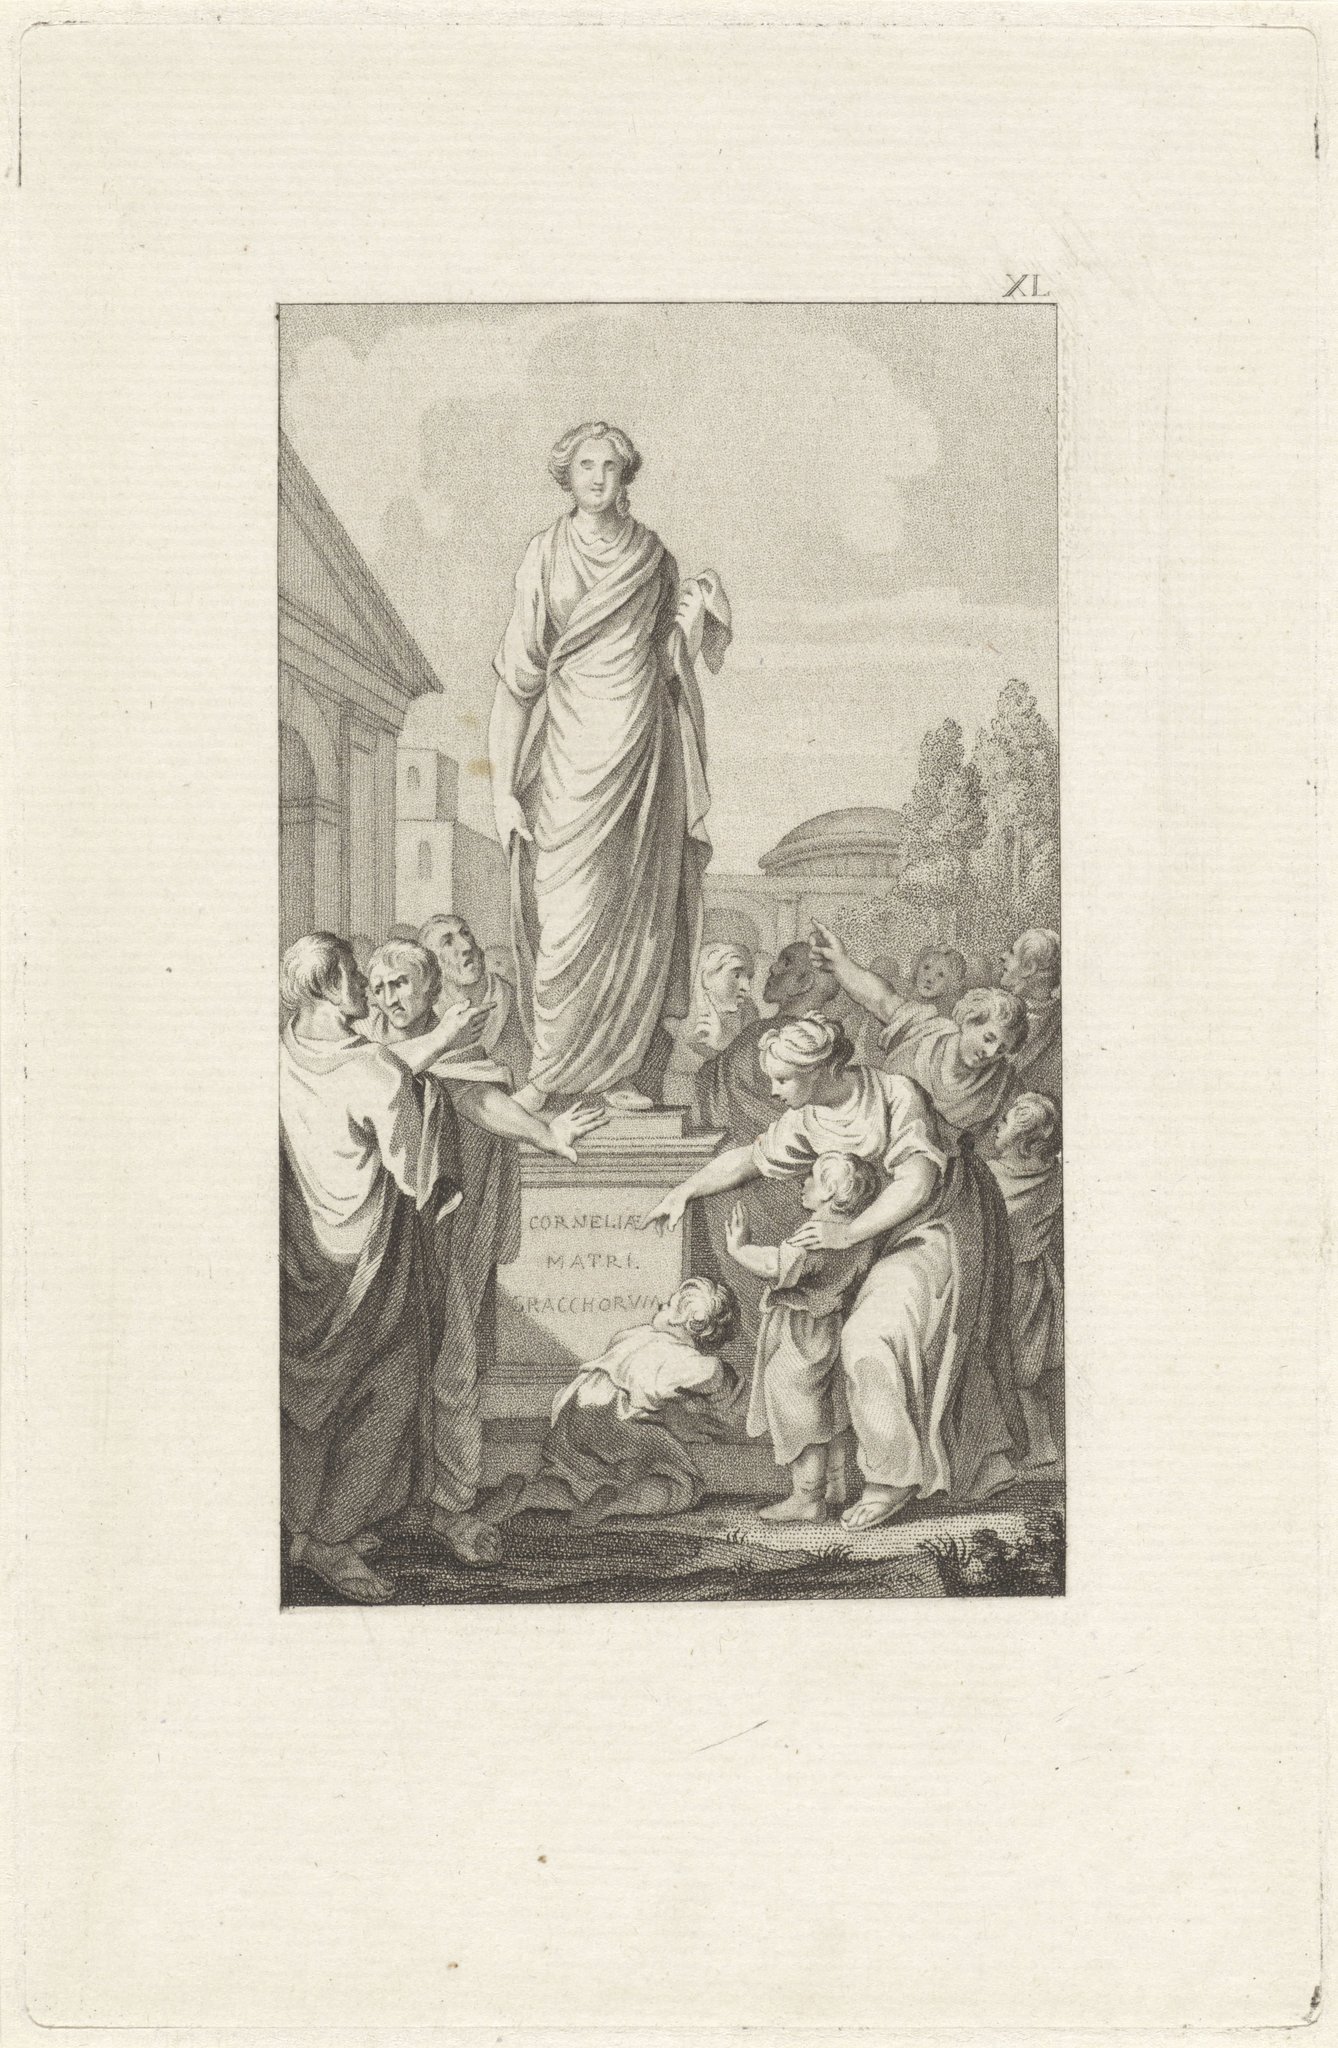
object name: book illustration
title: Voorstellen van Gracchus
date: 1797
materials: paper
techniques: etching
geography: amsterdam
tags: non-aggressive activities of cornelia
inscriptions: collector's mark: Lugt 2228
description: Tiberius Sempronius Gracchus III trekt, op verzoek van zijn moeder Cornelia, een hervorming in. Het volk is blij en men richt te harer ere een standbeeld op. Op de de piëdestal staat: "Cornelia, moeder van de Gracchen".